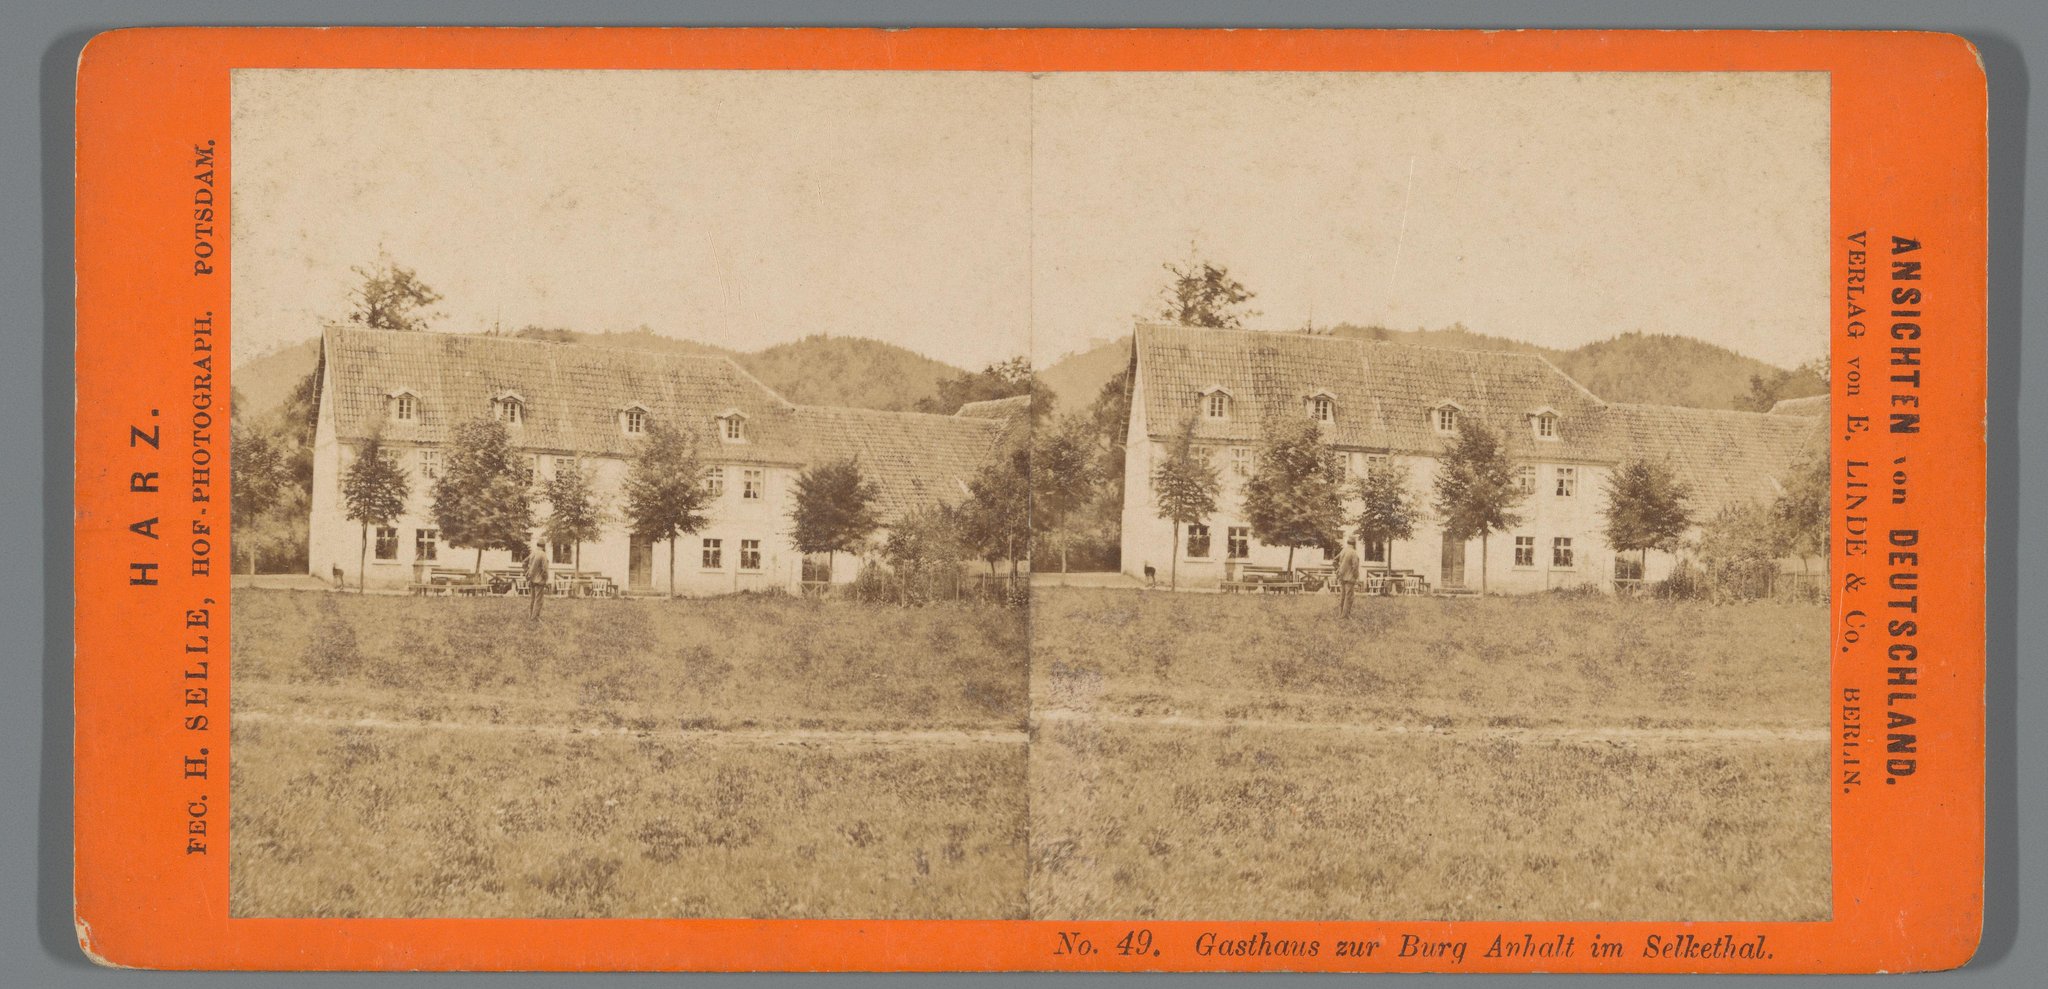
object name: stereograph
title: Harz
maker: hermann selle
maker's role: fotograaf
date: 1868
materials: cardboard, paper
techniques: albumen print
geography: harz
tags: hotel, hostelry, inn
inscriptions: number: ‘No. 49.’